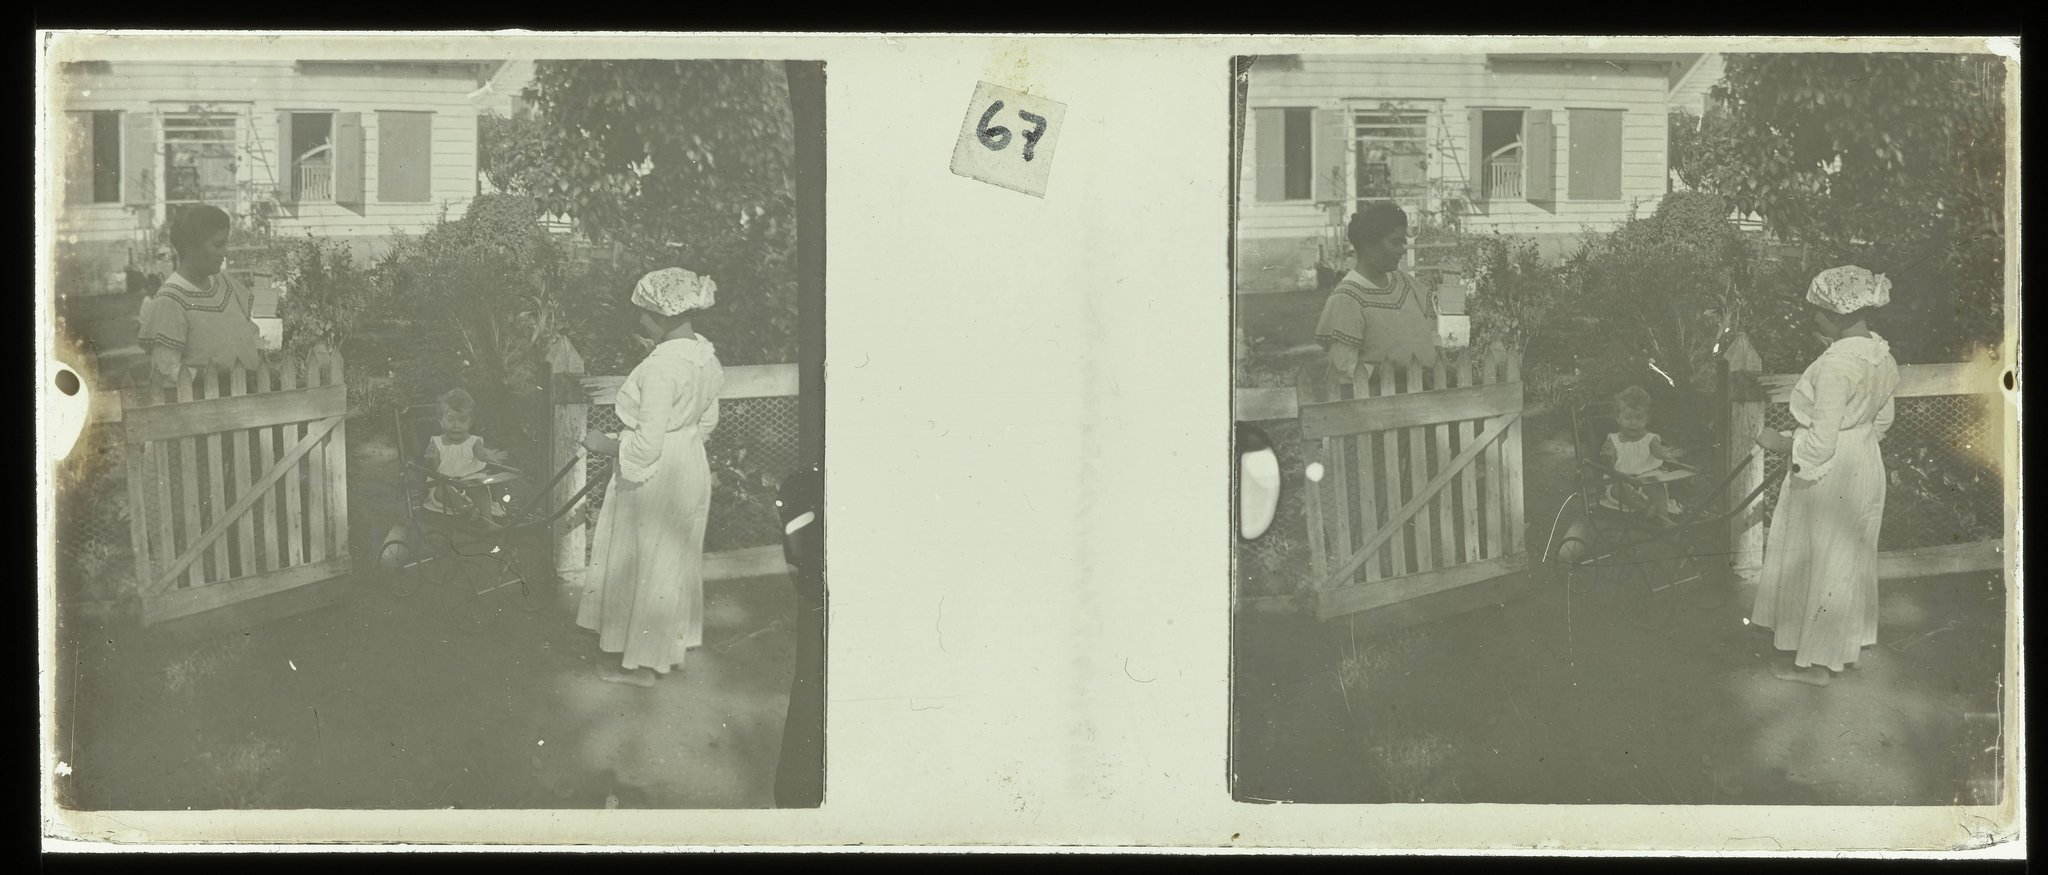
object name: stereograph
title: Nene Mathilde op plantage Accaribo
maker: theodoor brouwers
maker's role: amateurfotograaf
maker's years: 1874-1932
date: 1913-1930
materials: glass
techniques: photography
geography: suriname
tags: theodoor brouwers, plantation, suriname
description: In de periode 1911-1932 woonde op plantage Accaribo in Suriname de familie Brouwers van wie de foto's afkomstig zijn. Rond 1910 vond Theodoor Brouwers werk op plantage Accaribo. In 1929 werd hij eigenaar van de plantage. Op Accaribo werden in zijn tijd bananen geproduceerd en wat koffie.